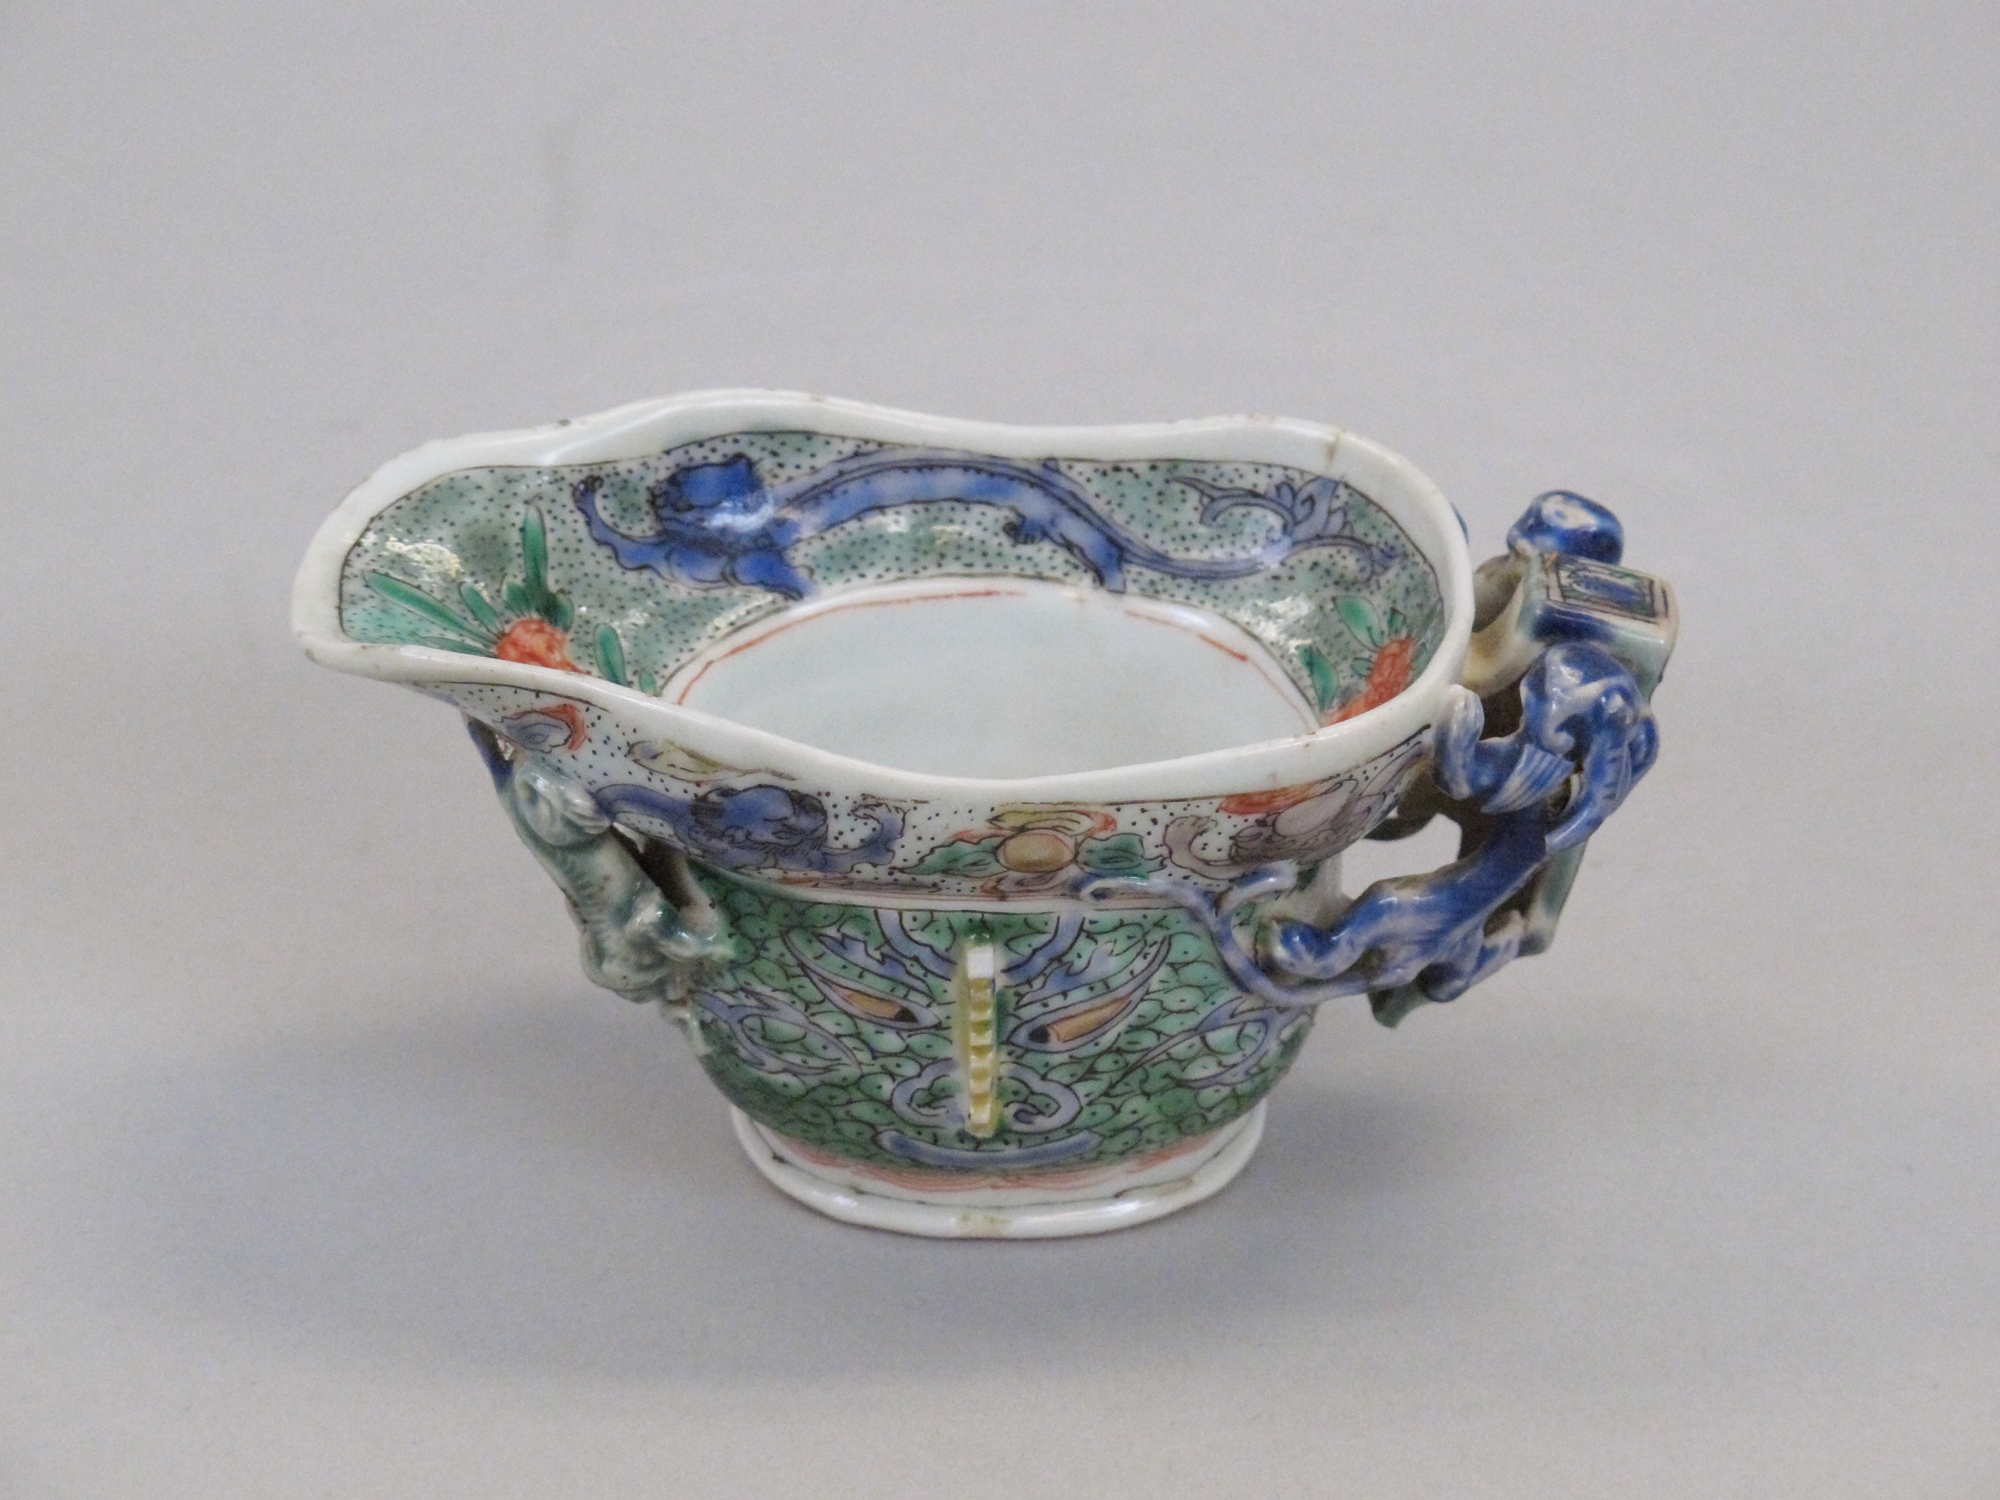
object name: cup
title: Sacrificial Cup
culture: chinese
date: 1701-1800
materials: enamel, porcelain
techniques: overglaze, painting, polychrome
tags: mythical creatures